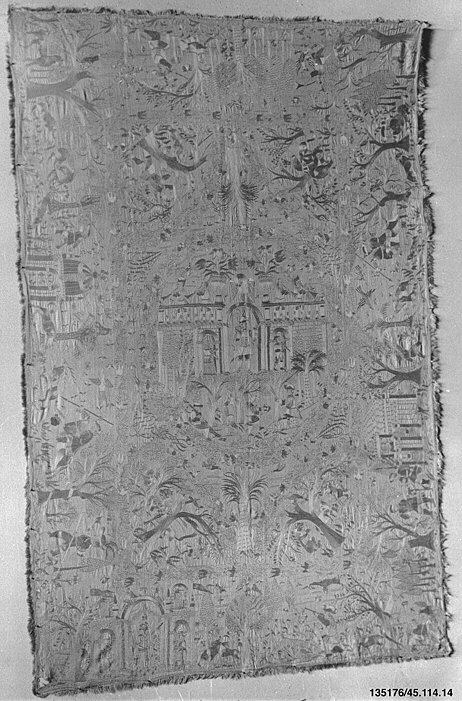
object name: cover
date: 1701-1800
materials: linen, silk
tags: buildings,trees